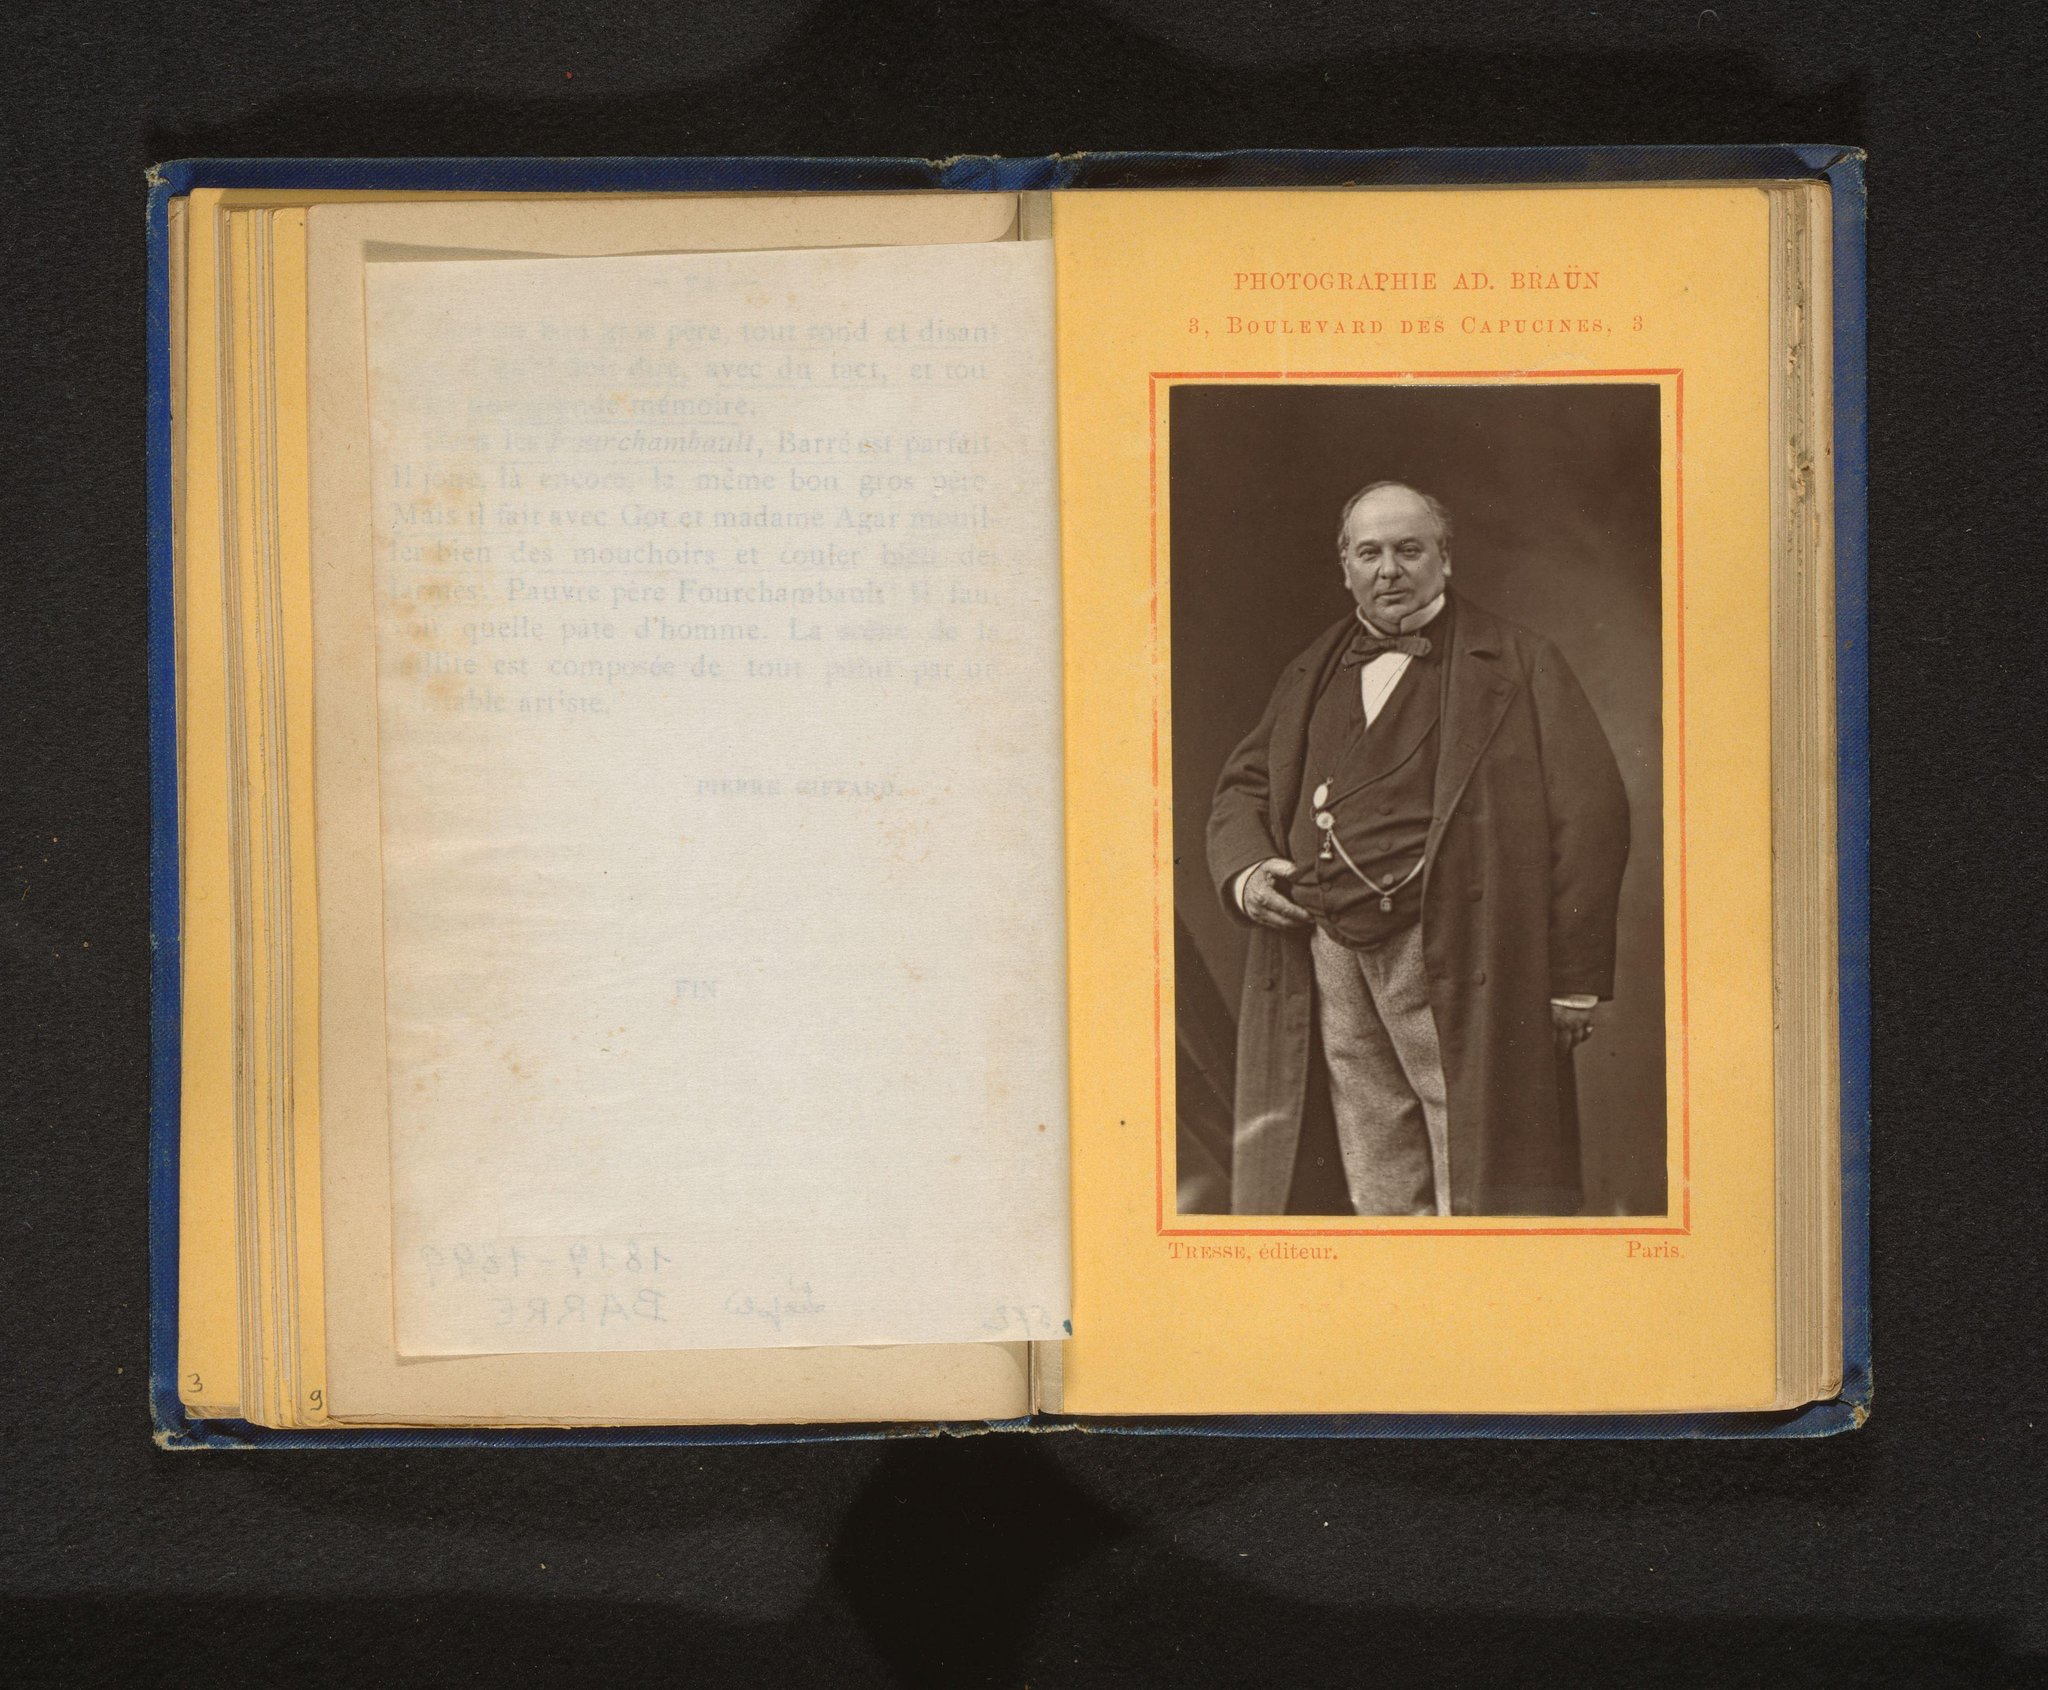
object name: photomechanical print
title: Portret van Léopold Barré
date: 1868-1878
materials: paper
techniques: woodburytype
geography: paris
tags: portrait of actor, actress